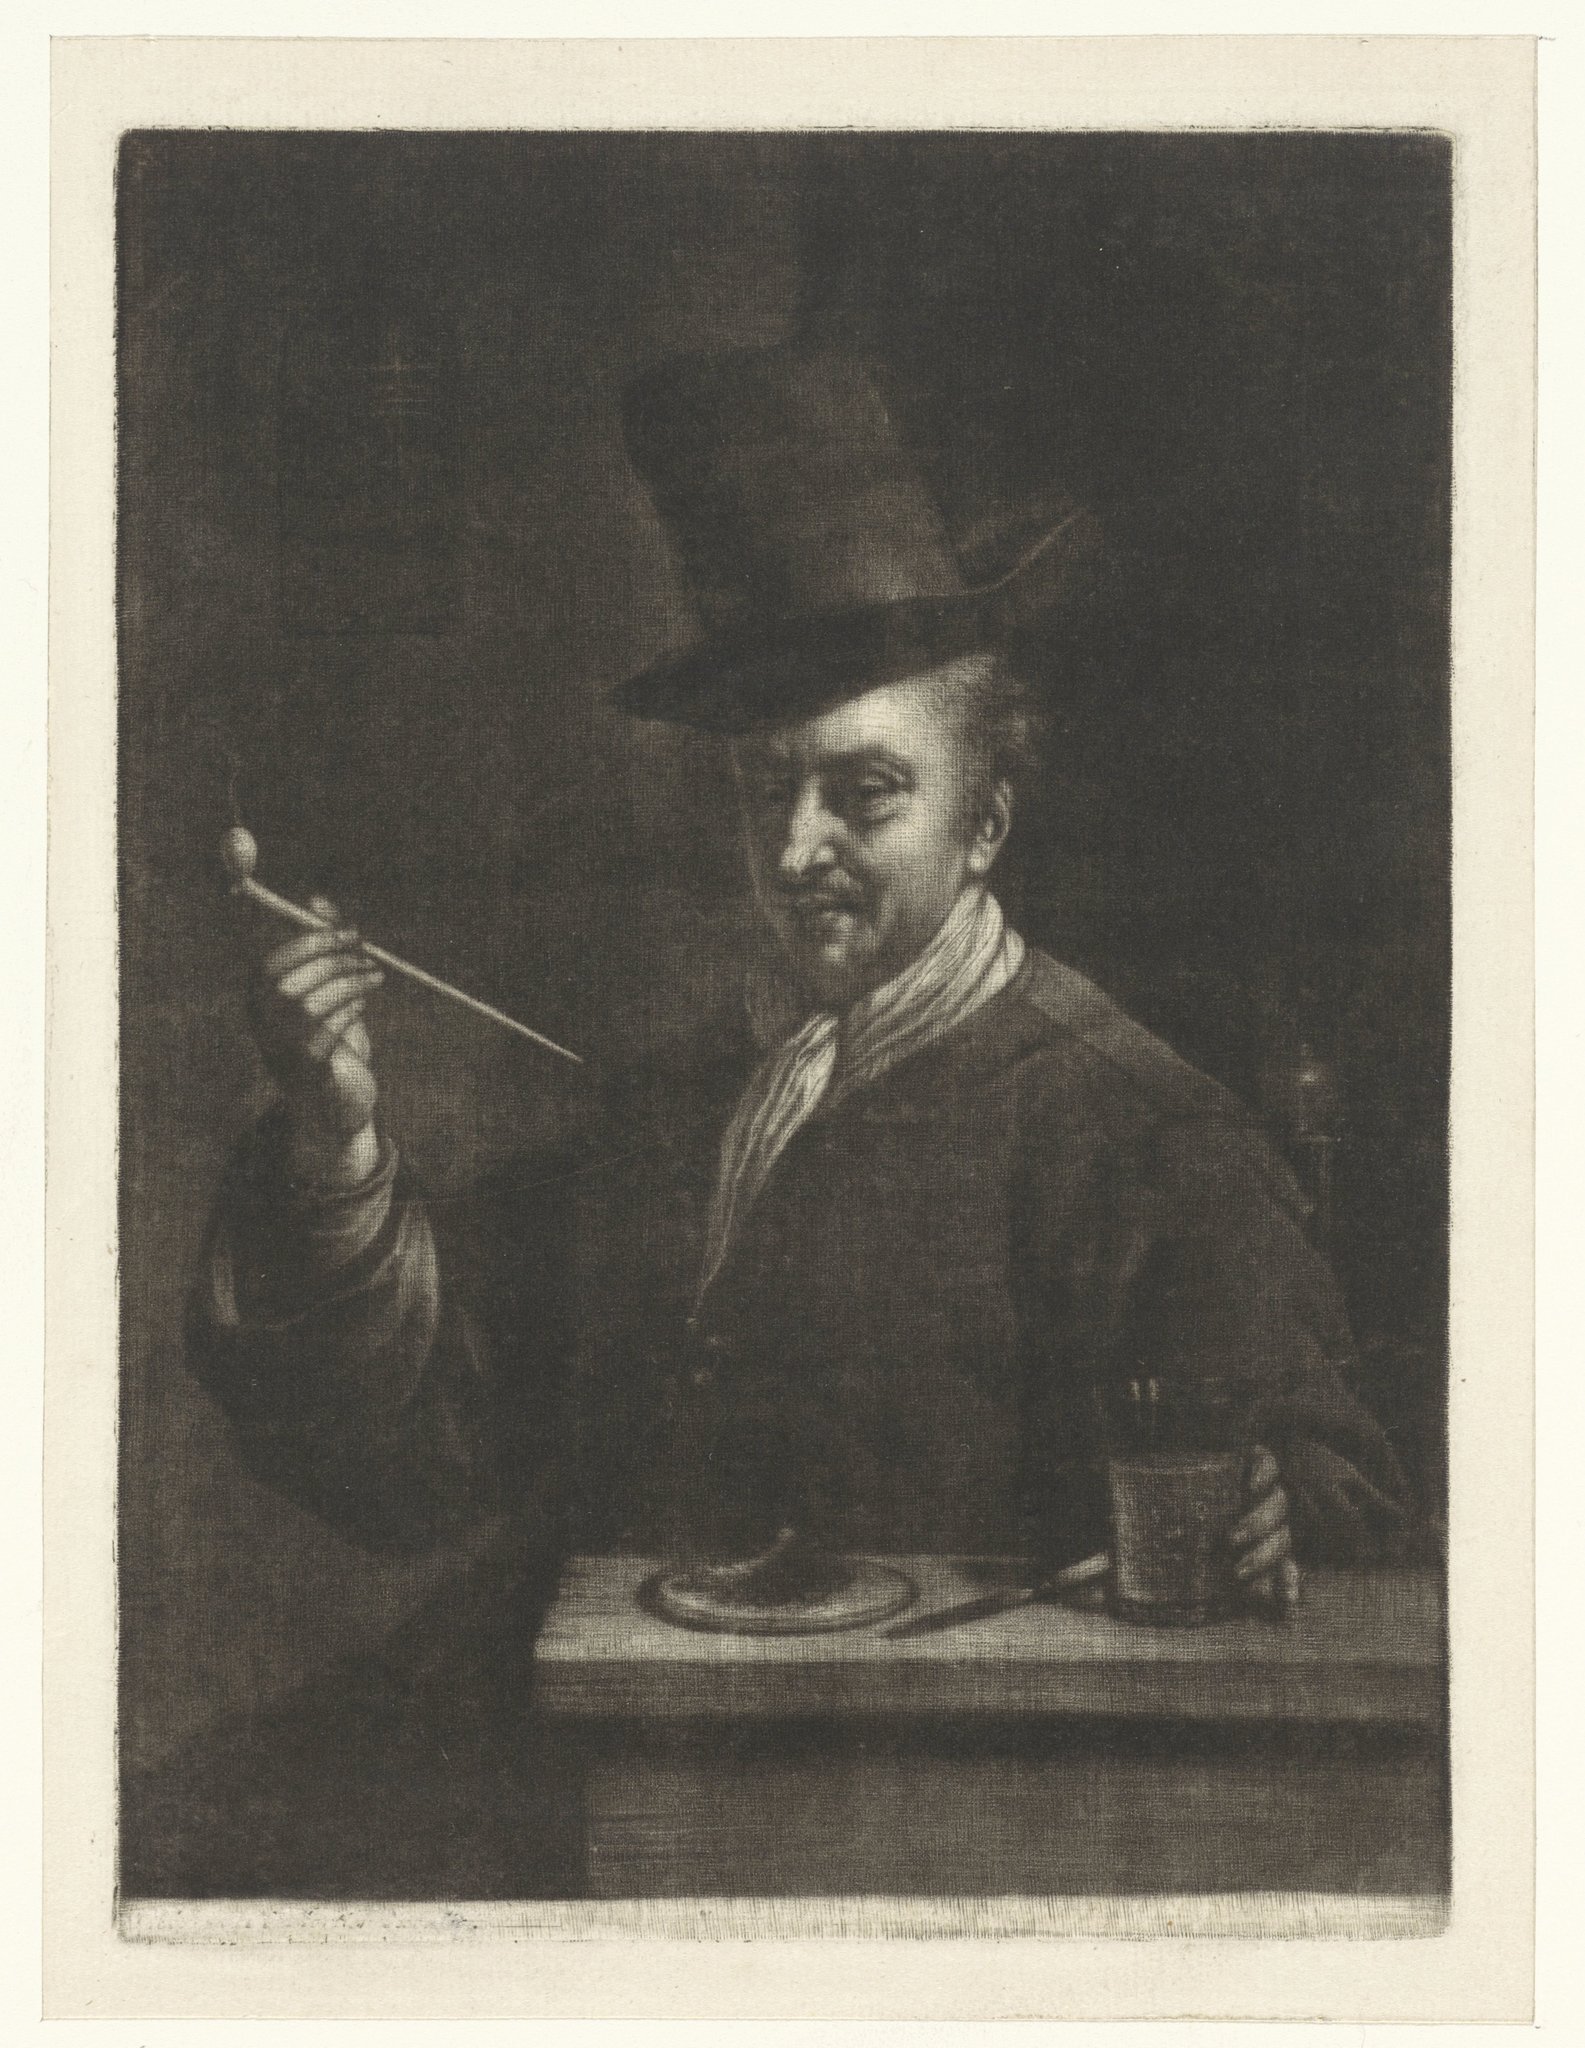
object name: print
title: Pijprokende man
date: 1658-1677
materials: paper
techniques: mezzotint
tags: pipe ~ tobacco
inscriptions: collector's mark: Lugt 964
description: Een man met een hoge hoed zit aan een tafel pijp te roken. In zijn hand heeft hij een glas.